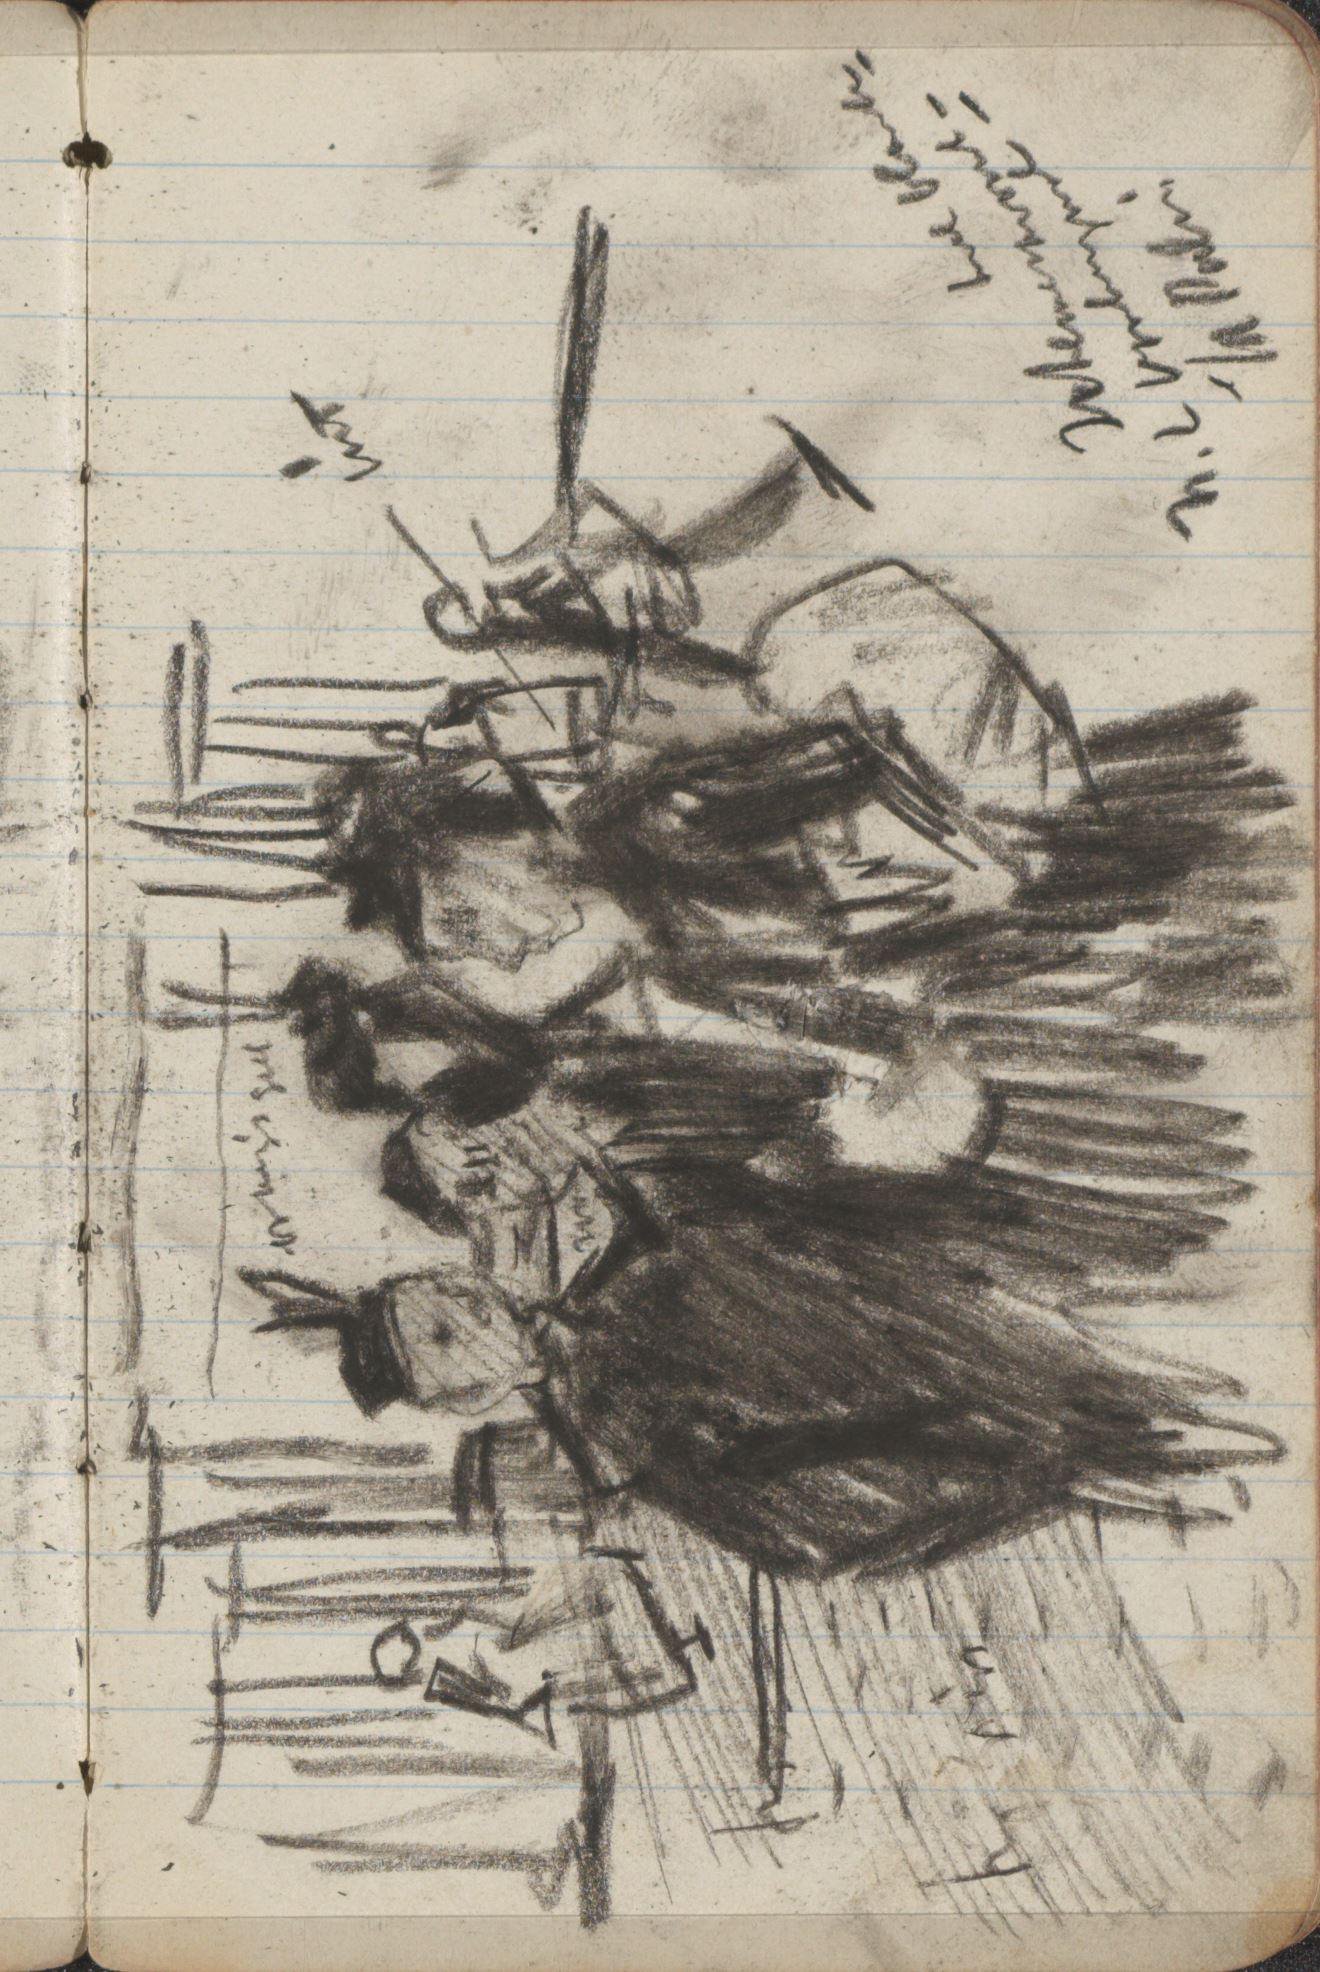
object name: sketchbook leaf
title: Jonge vrouwen op de hoek van de Nieuwezijds Voorburgwal en de Paleisstraat te Amsterdam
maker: george hendrik breitner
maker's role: draughtsman, painter, print maker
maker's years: 1857-1923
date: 1894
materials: chalk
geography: amsterdam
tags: adolescent, young woman, maiden, street (+ city(-scape) with figures, staffage)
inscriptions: annotation: ‘[...]/ schemeravond/ N.Z Voorburgwal/ [...] Paleis’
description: Pagina 26 uit een schetsboek met 31 bladen.